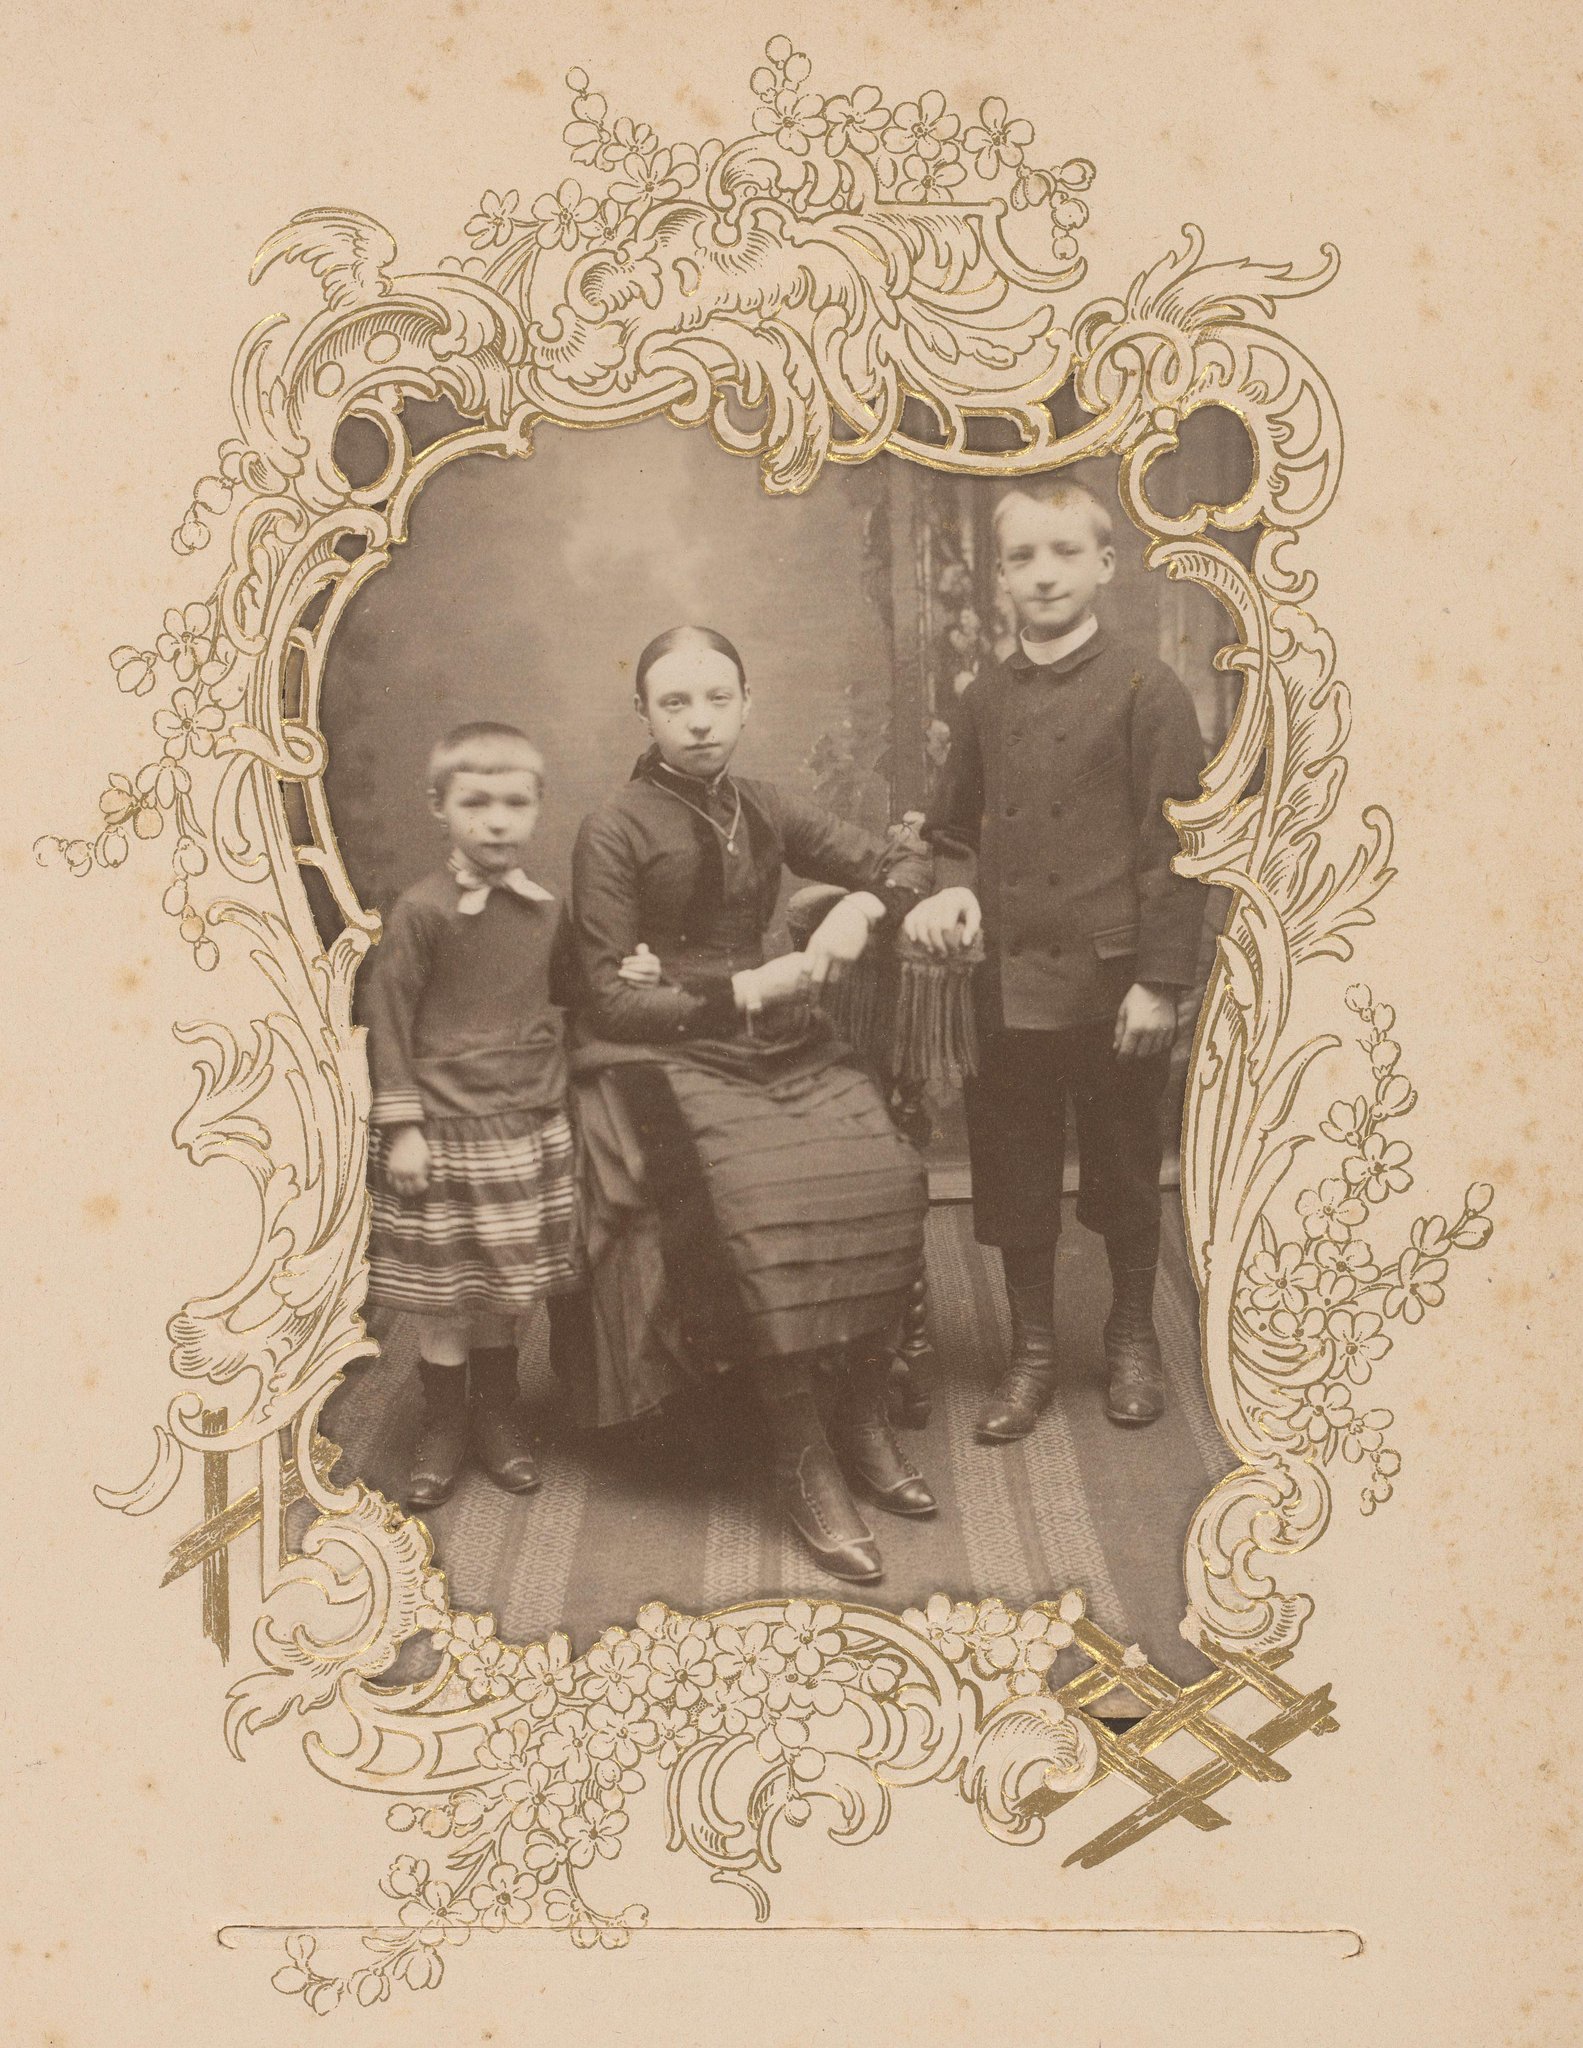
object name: photograph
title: Groepsportret van drie kinderen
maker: Anonymous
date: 1860-1890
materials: cardboard, photographic support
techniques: albumen print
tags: child, anonymous historical persons portrayed in a group, in a group-portrait